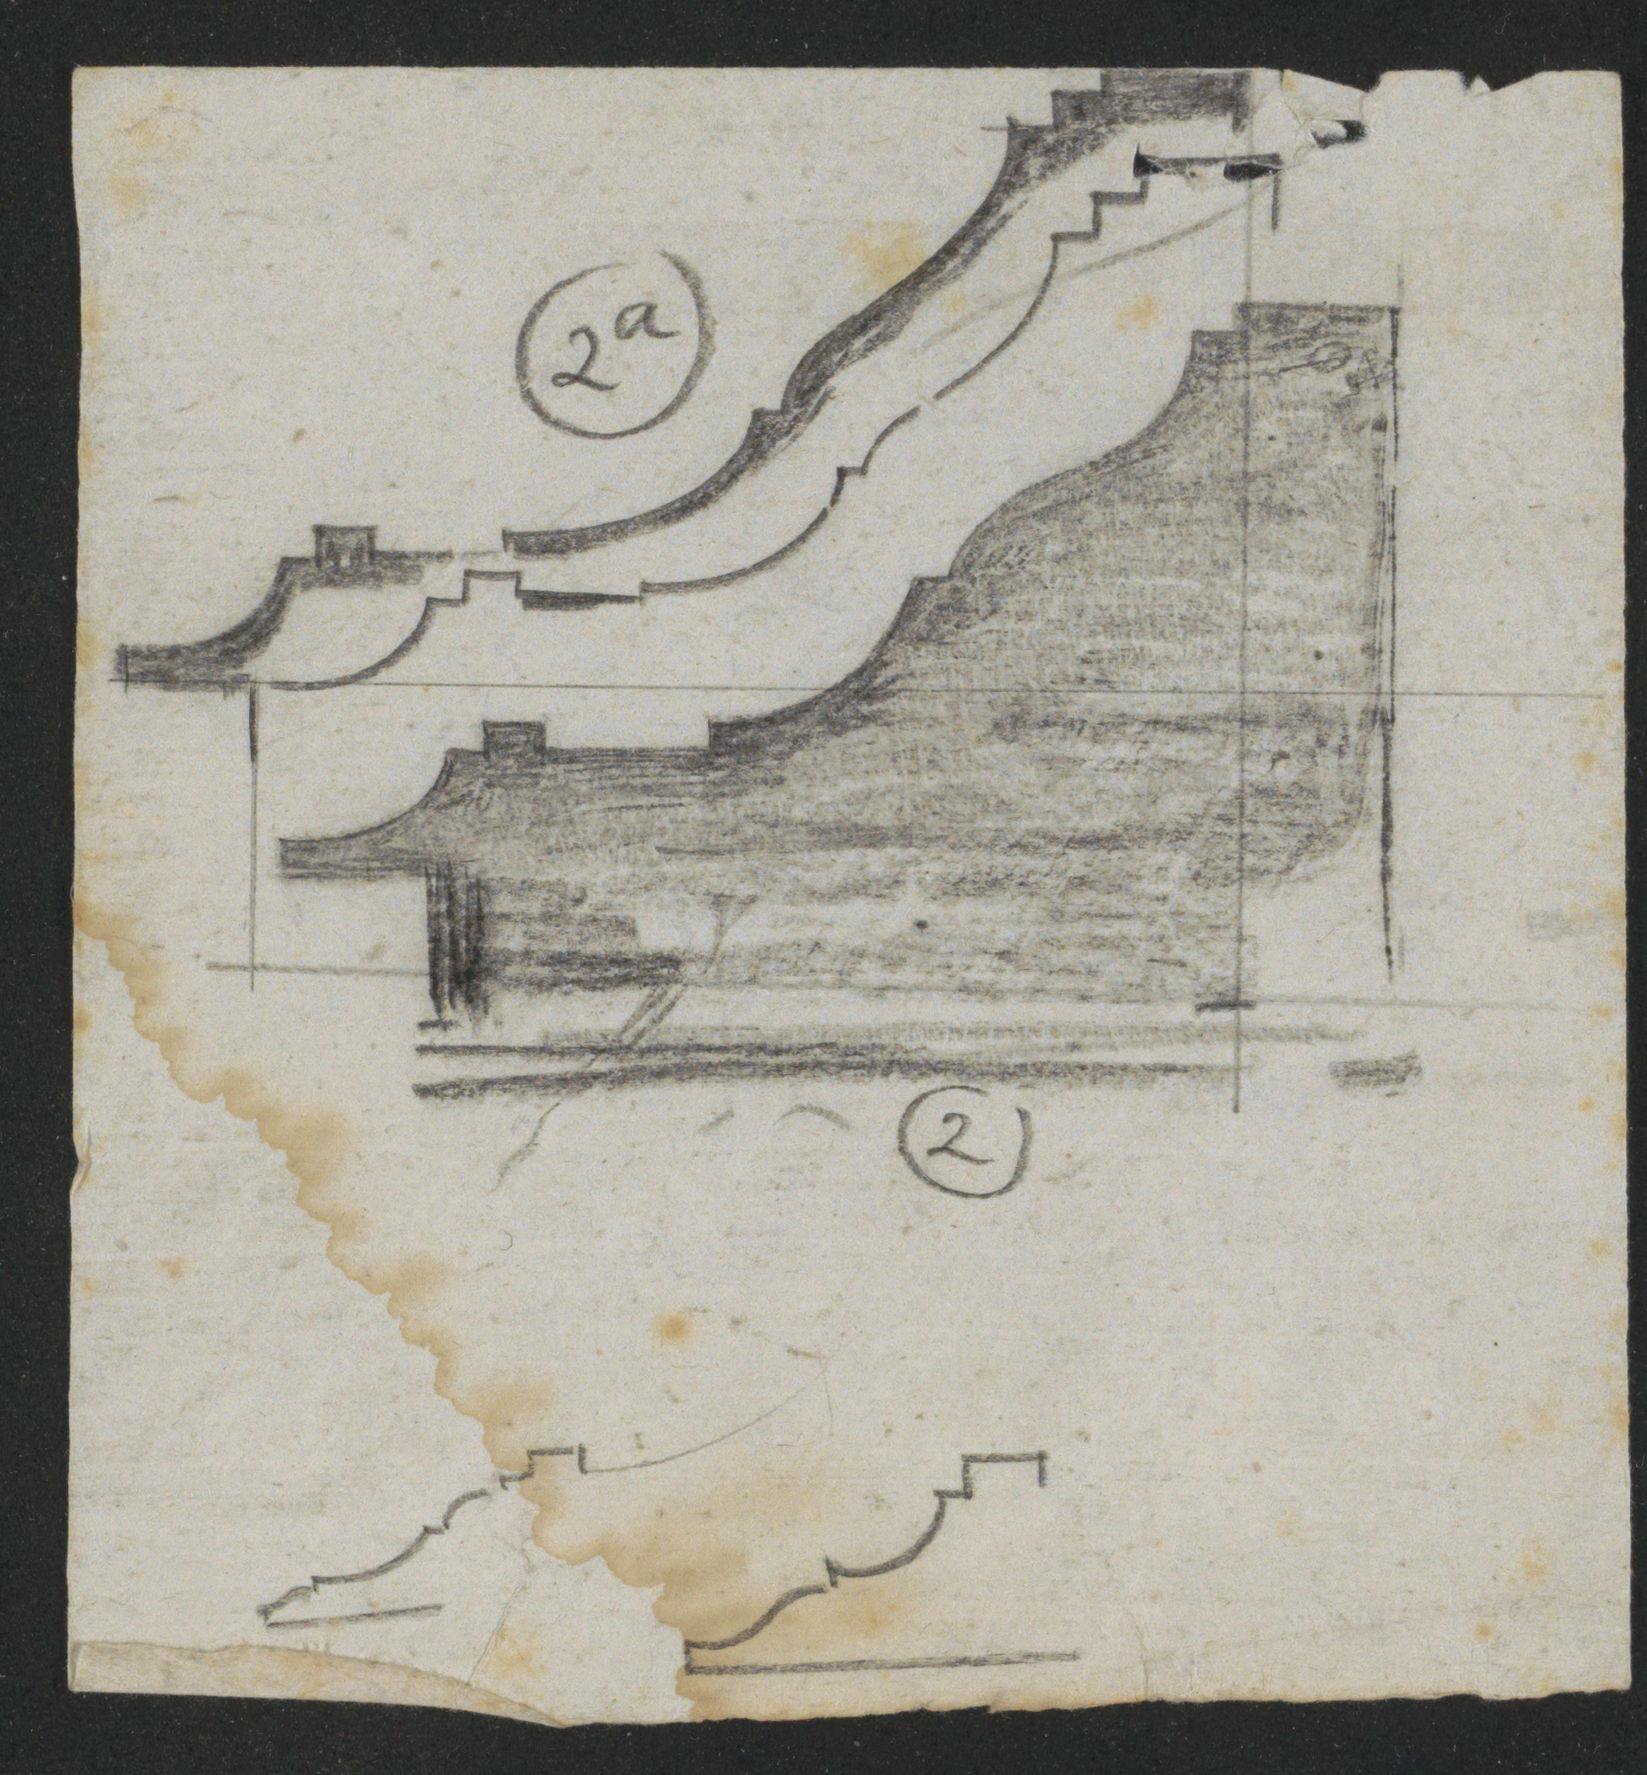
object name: drawing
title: Doorsneden van een schilderijlijst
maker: gerrit willem dijsselhof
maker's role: designer, draughtsman, print maker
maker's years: 1866-1924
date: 1876-1924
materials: chalk, paper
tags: frame of painting, etc.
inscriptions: number: ‘2a/ 2’